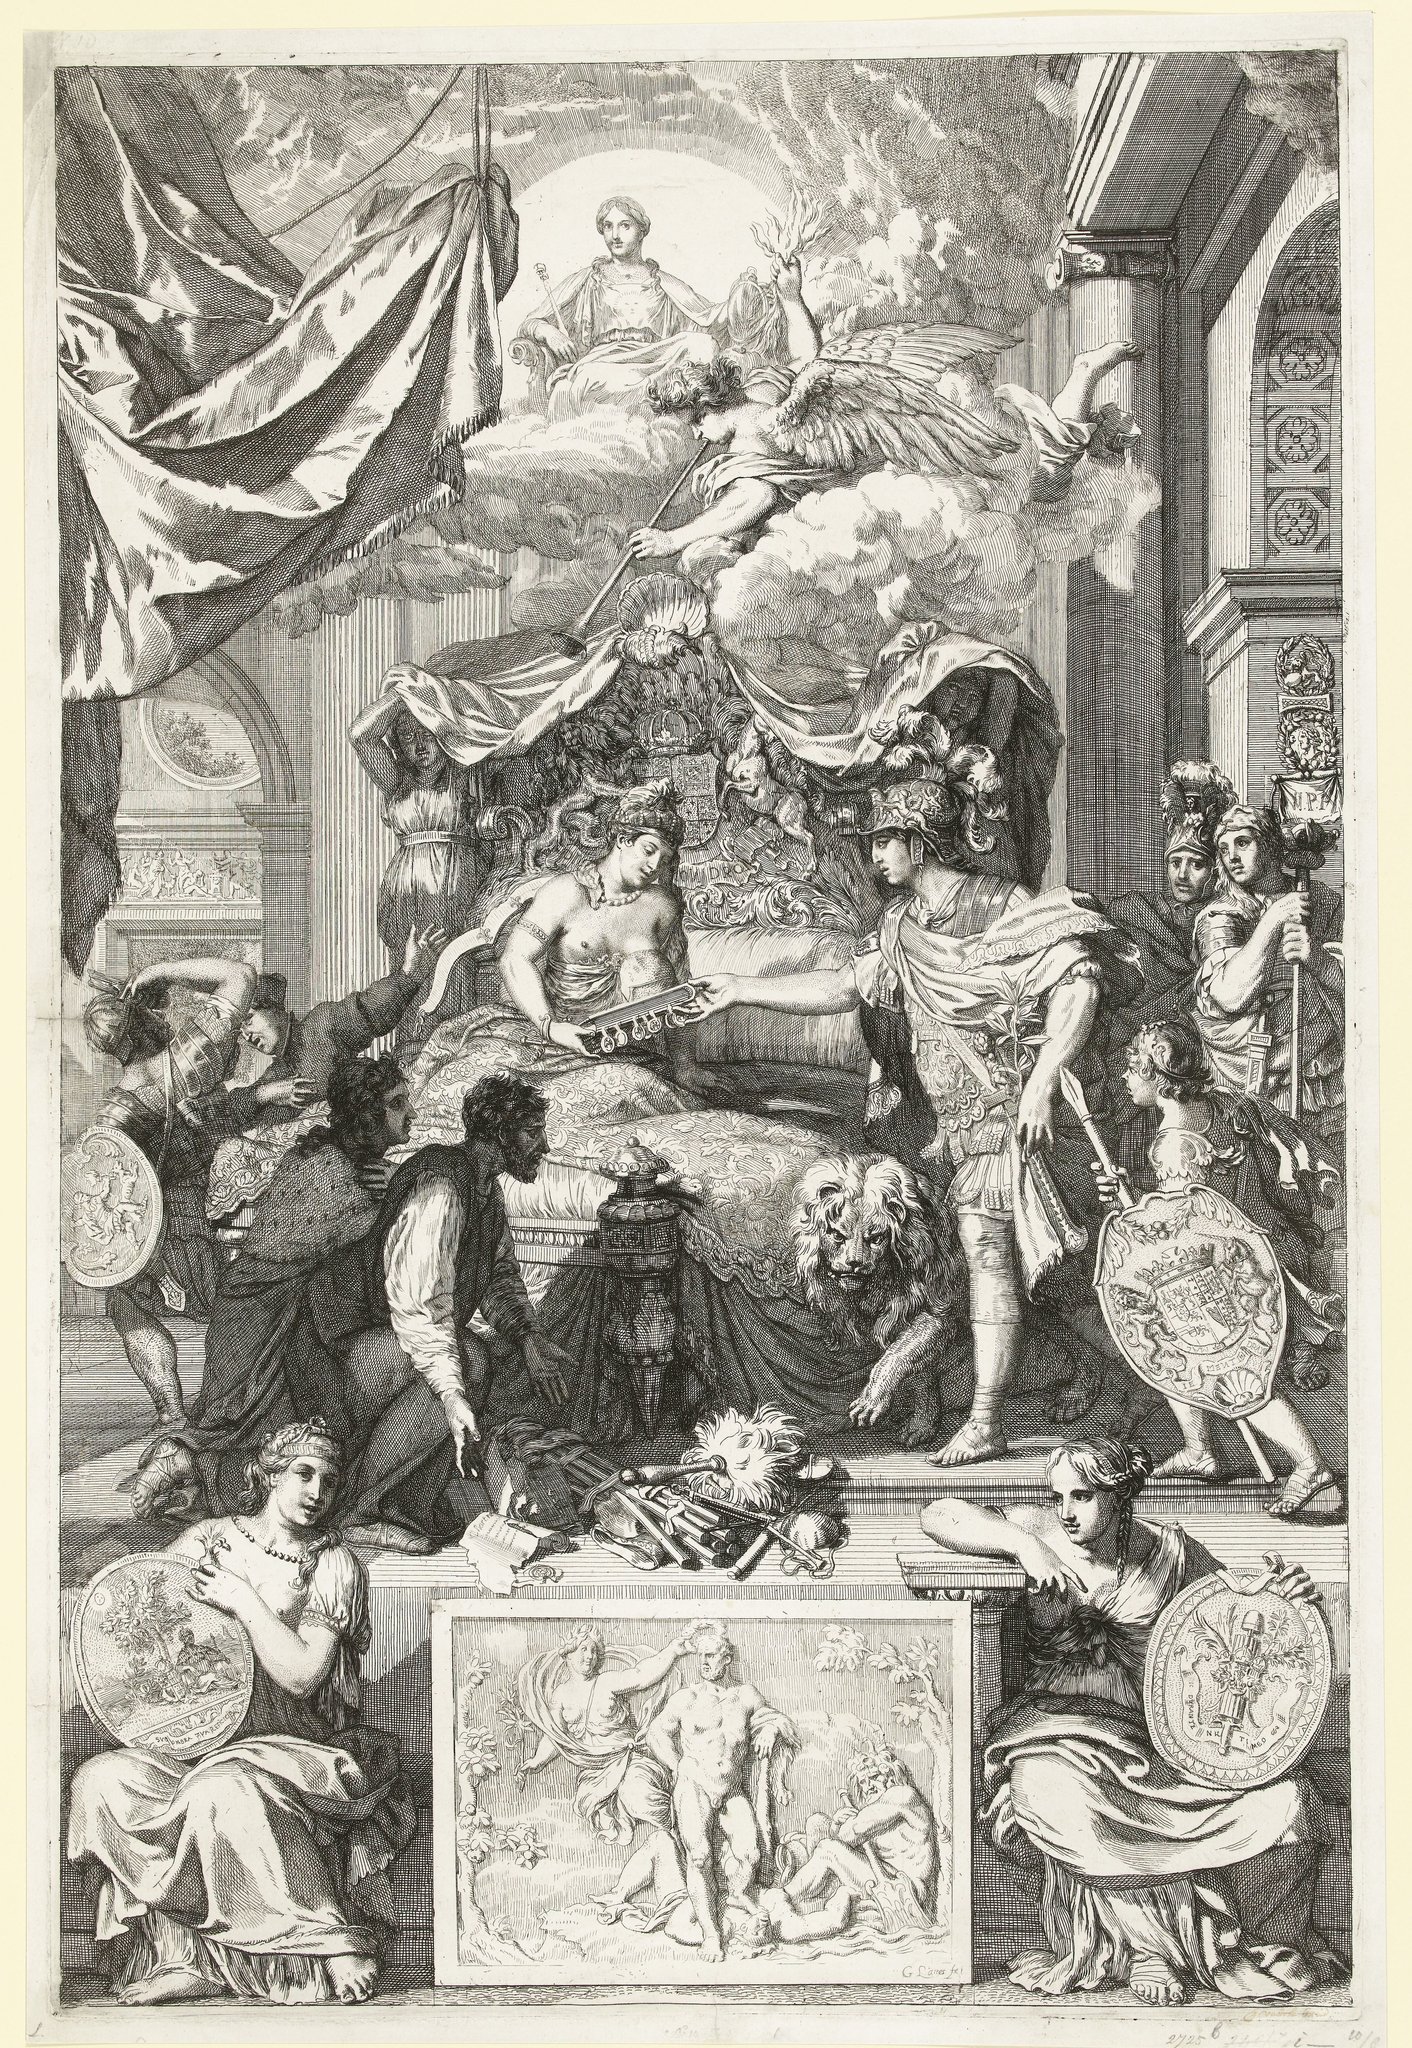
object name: propagandaprent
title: Allegory of the Primacy of the ‘True Faith’ in England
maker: gerard de lairesse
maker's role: draughtsman, painter, print maker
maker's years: 1641-1711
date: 1688-1689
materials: paper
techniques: etching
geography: northern netherlands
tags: the hague, william iii (prince of orange and king of england, scotland, and ireland), personifications of countries, nations, states, districts, etc., truth; 'verità' (ripa), england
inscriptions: inscription: ‘G. Valck excud.’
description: The arrival of the Protestant William III to England, leading an invading army, put an end to the rule of the Catholic king James II. Dressed as a Roman commander, William III presents a sealed Bible to the English Maid. She lies alone in bed, abandoned by her lord and master – the fugitive James II.